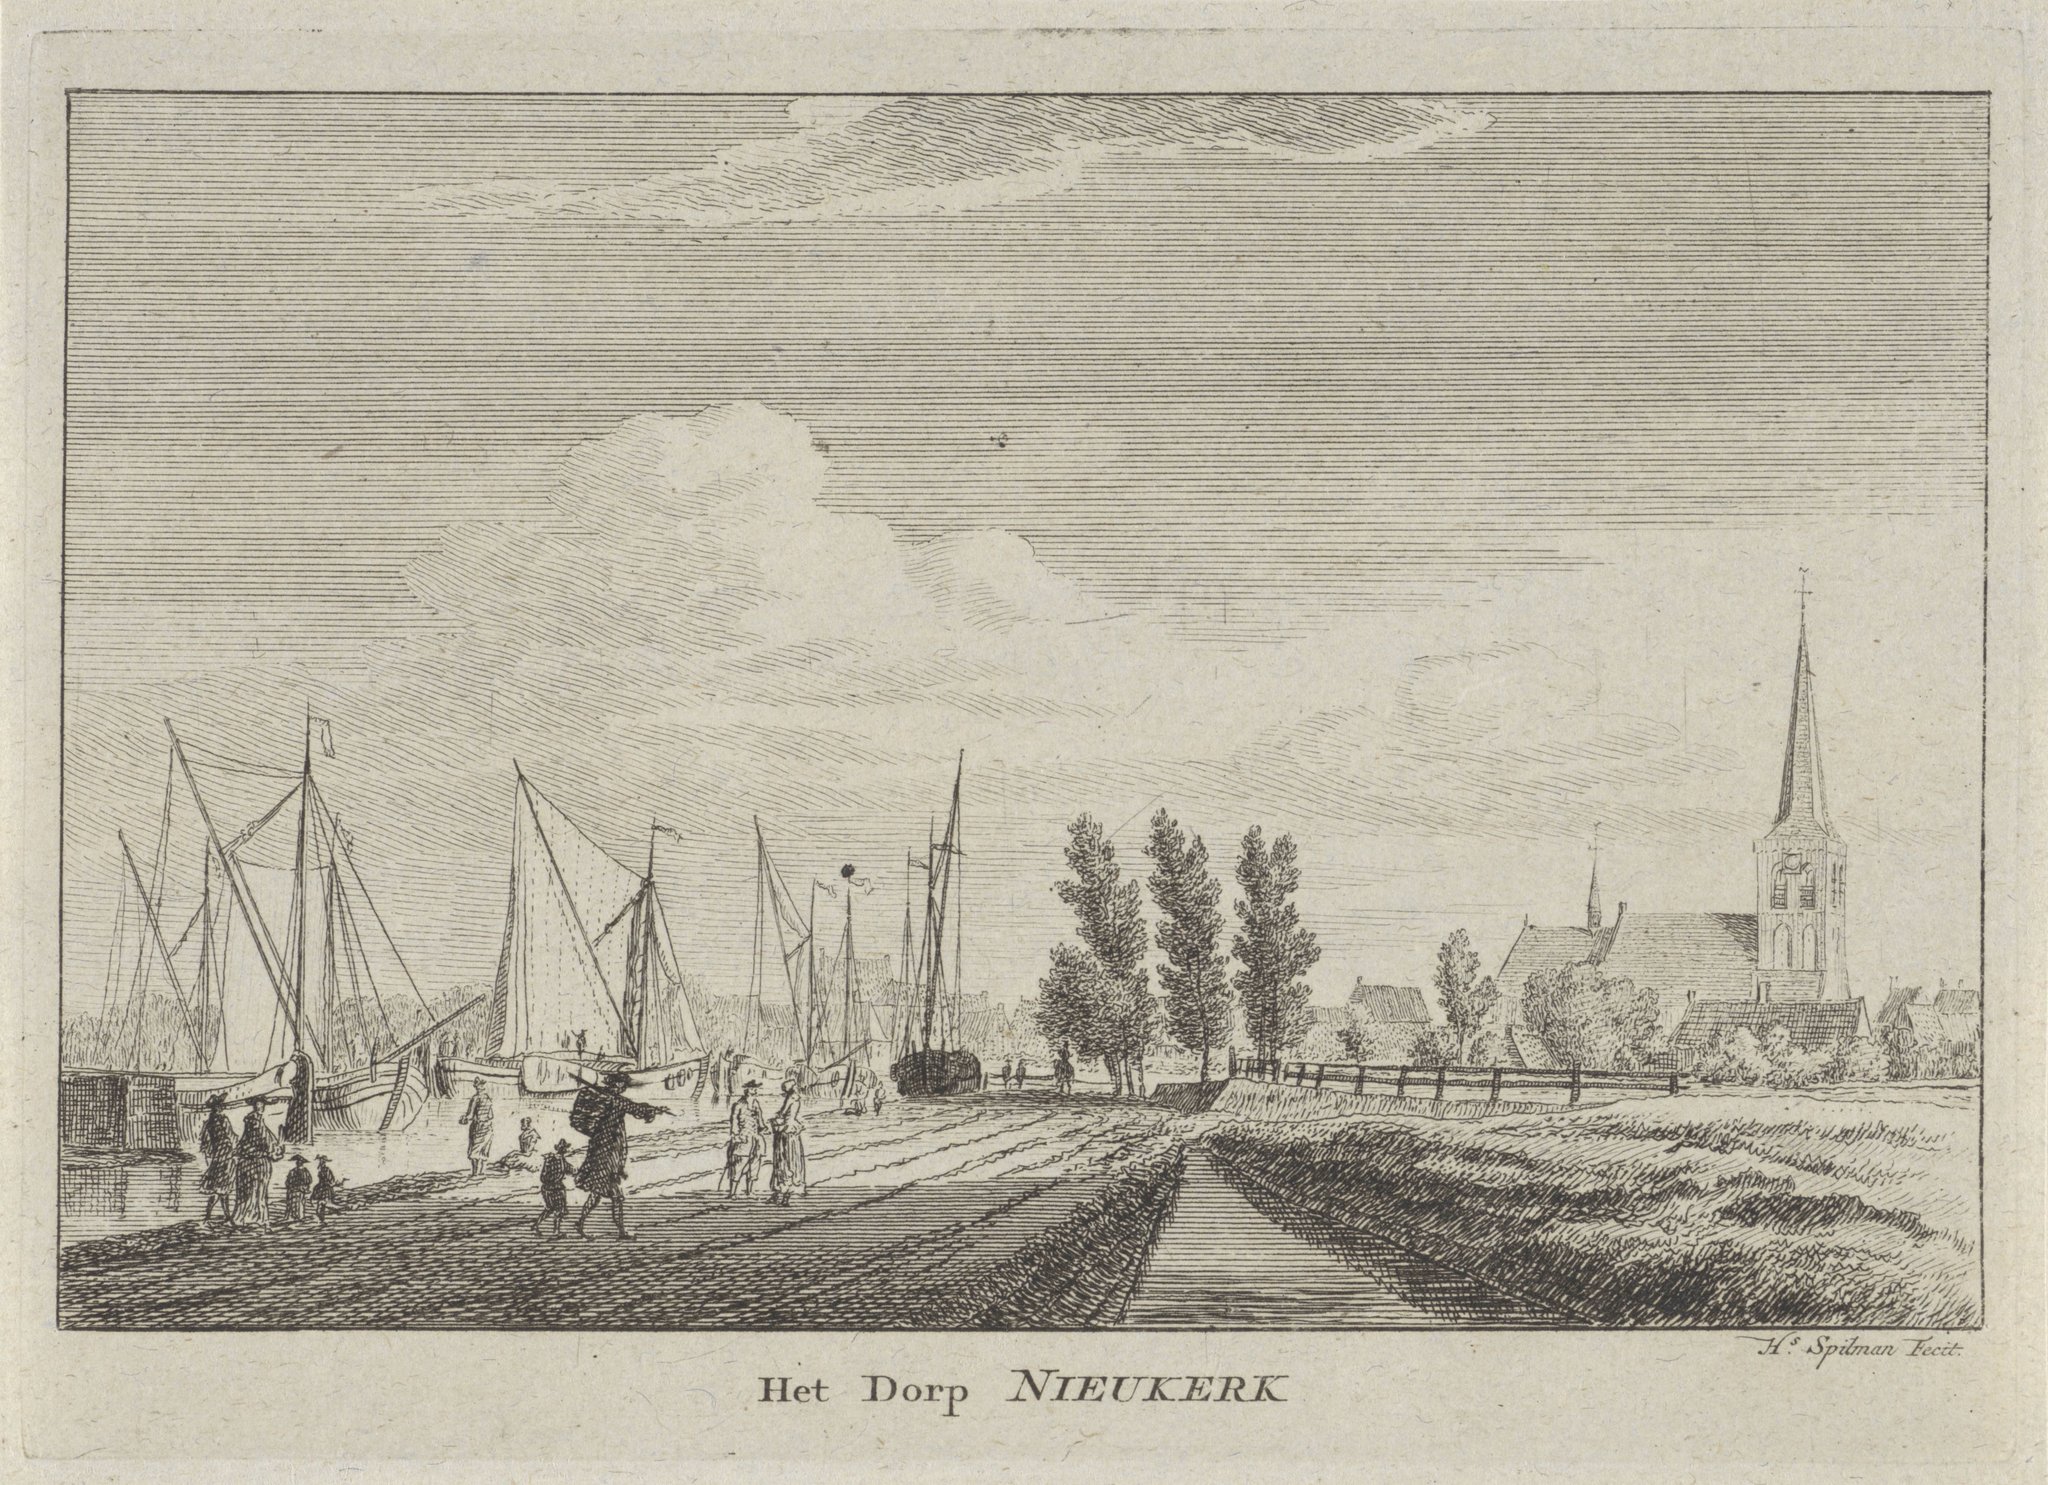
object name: print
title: Het Dorp Nieukerk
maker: hendrik spilman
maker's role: draughtsman, painter, print maker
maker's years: 1721-1784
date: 1742-1784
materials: paper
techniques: etching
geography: haarlem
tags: sailing-ship, sailing-boat, church (exterior)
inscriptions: collector's mark: Lugt 2228